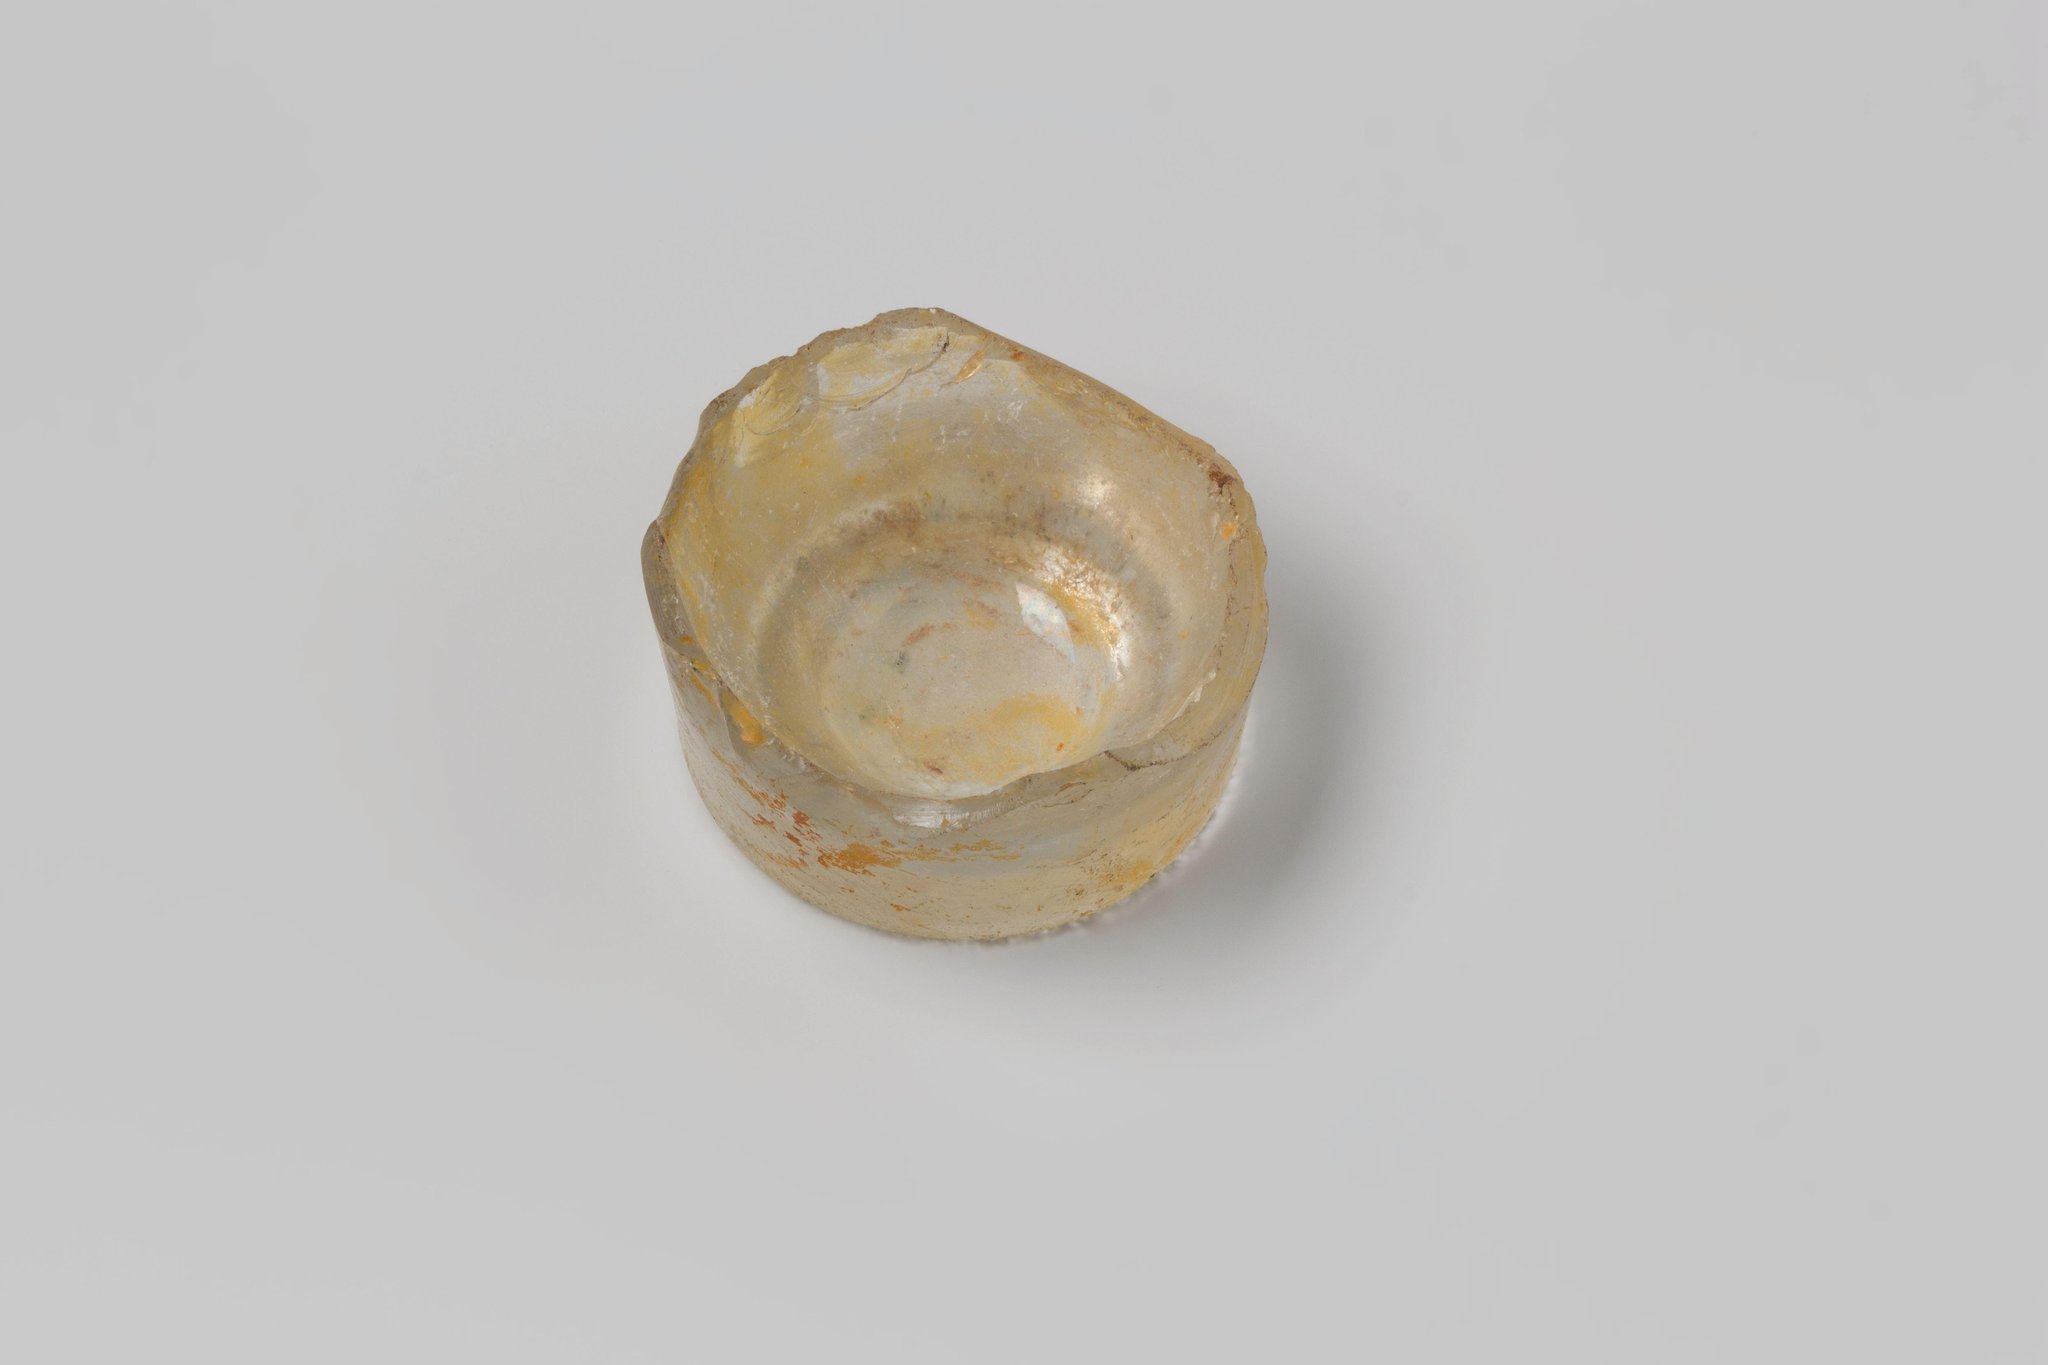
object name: drinking glass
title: Fragment tuimelaar uit het wrak van de Oost-Indiëvaarder Hollandia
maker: Anonymous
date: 1700-1743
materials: glass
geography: netherlands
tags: verenigde oostindische compagnie, hollandia (schip), annet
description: Base, circular, flat, slightly everted sides. Tumbler.